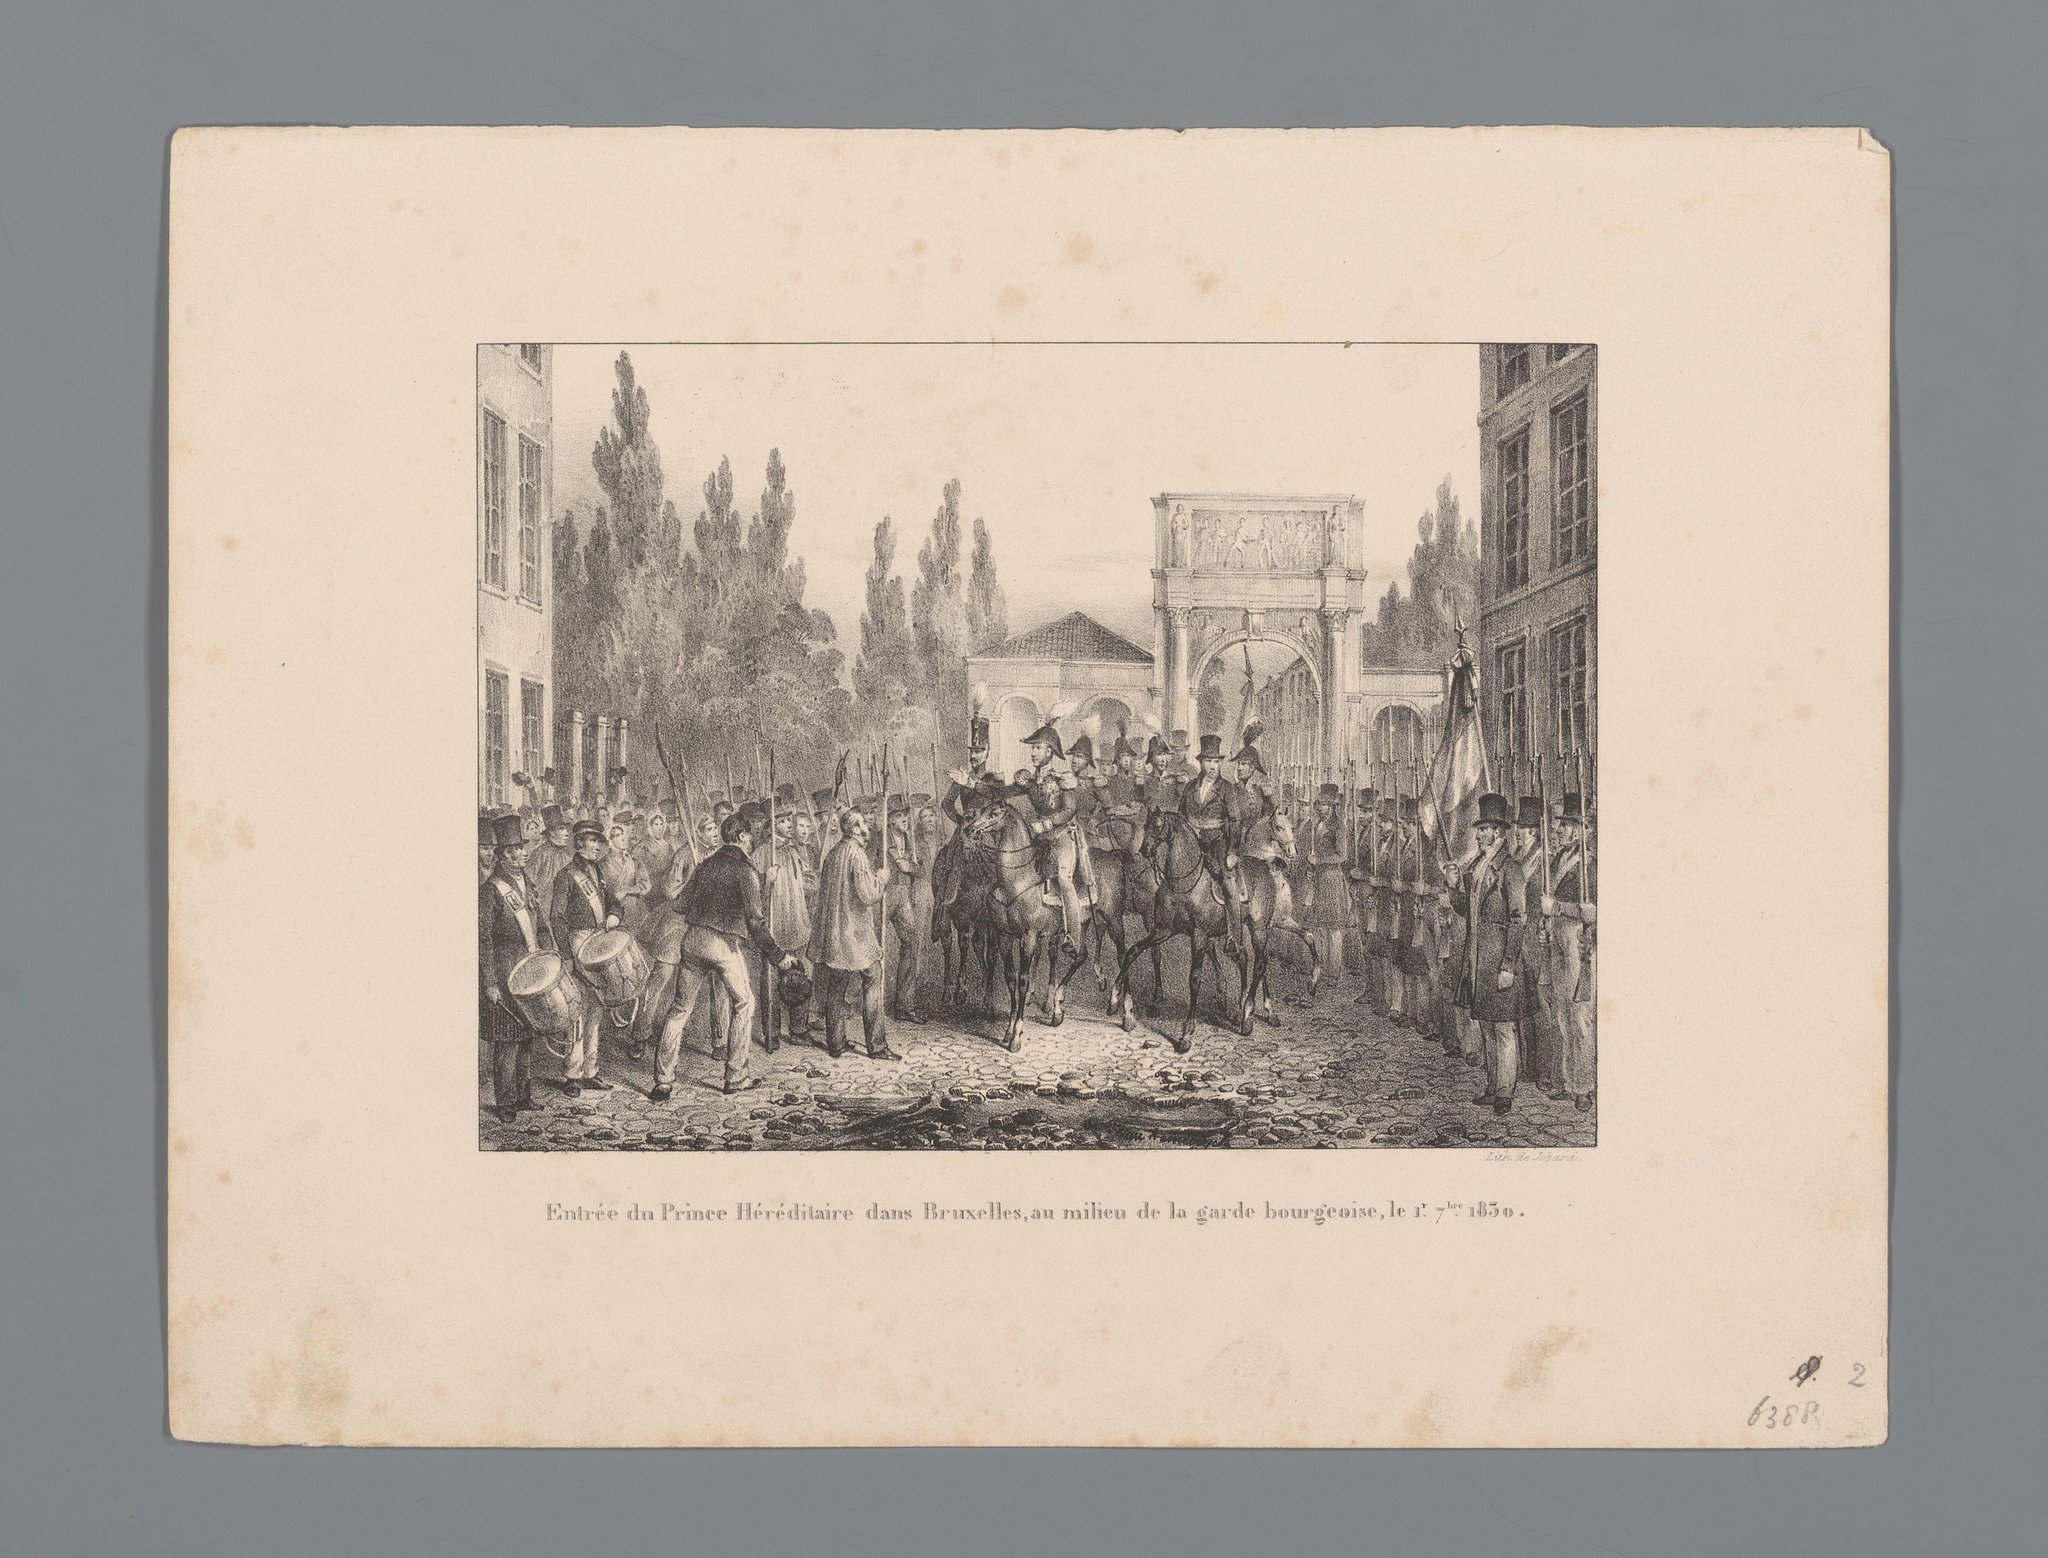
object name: print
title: Evénemens de la Belgique Dessinés sur les lieux par des témoins oculaires, Bruxelles, à la Lithographie de Jobard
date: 1830-1831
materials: paper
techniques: lithograph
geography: brussels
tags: the hague, william ii of the netherlands, city-view, and landscape with man-made constructions, city-gate, brussels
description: Onderdeel van een groep van prenten afkomstig uit verschillende andere series maar toegevoegd aan het recueil over de gebeurtenissen tijdens de Belgische Revolutie in Brussel, Antwerpen en andere steden in de periode 25 augustus 1830 tot 27 maart 1831. Uitgegeven in de serie van 23 prenten getiteld: Evénemens de la Belgique Dessinés sur les lieux par des témoins oculaires, Bruxelles, à la Lithographie de Jobard, éditeur, [1831].